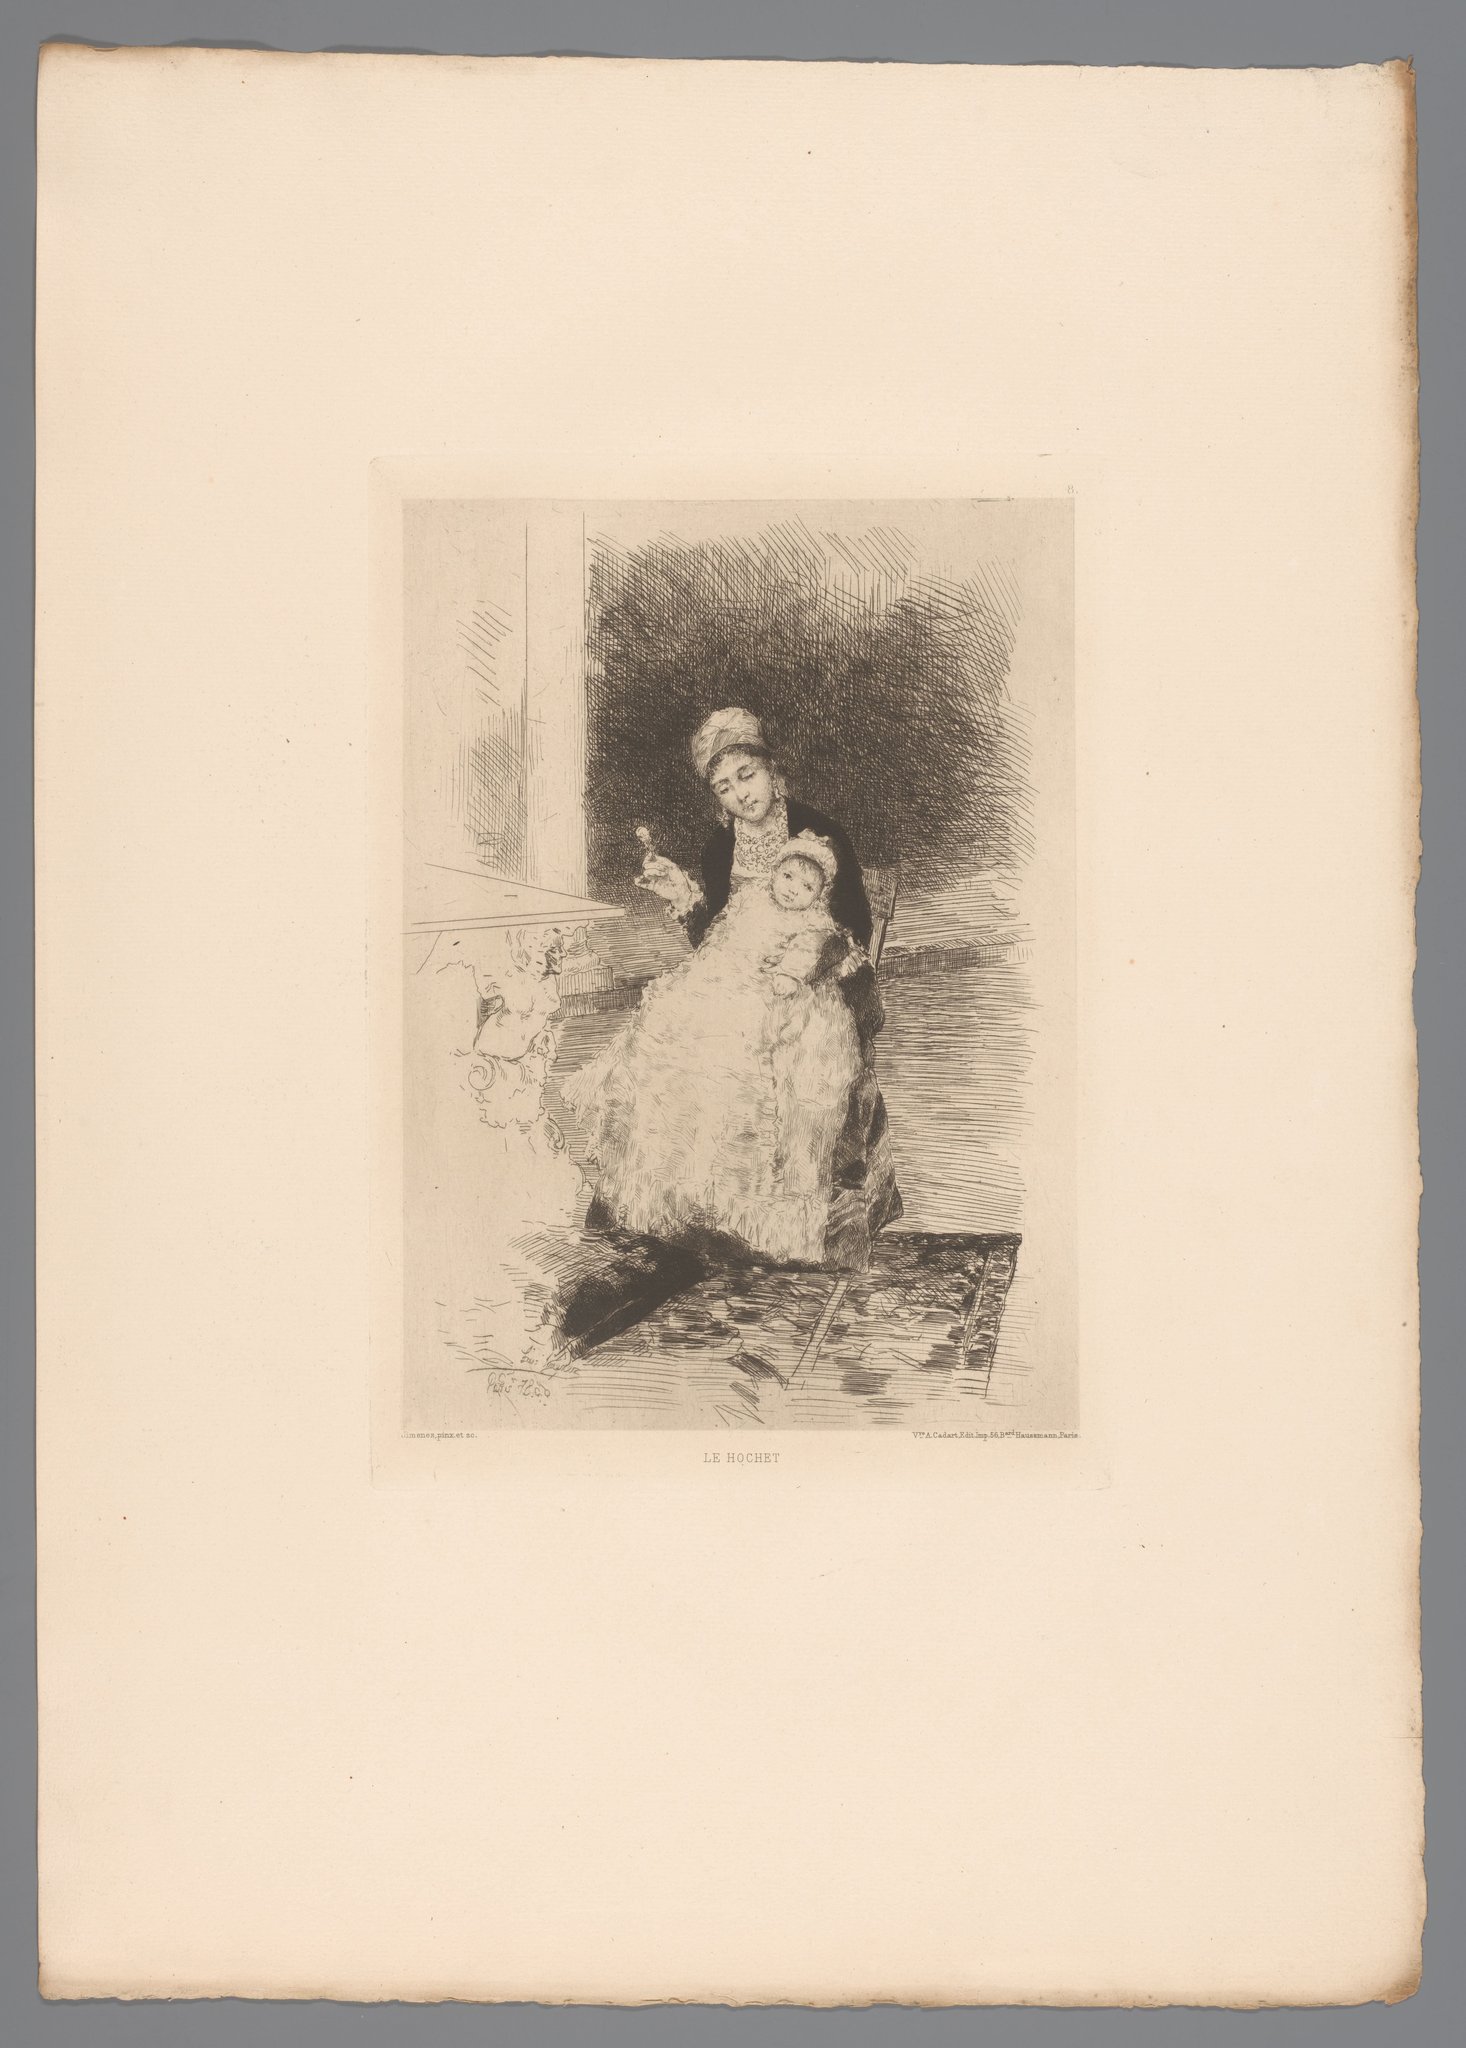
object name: print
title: L'eau-forte en 1879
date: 1879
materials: paper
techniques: drypoint, etching, intaglio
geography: paris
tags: mother and baby or young child, rattle (child's toy)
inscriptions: collector's mark: Lugt 2760, collector's mark: ‘AFE v S’, watermark, collector's mark: Lugt 2228